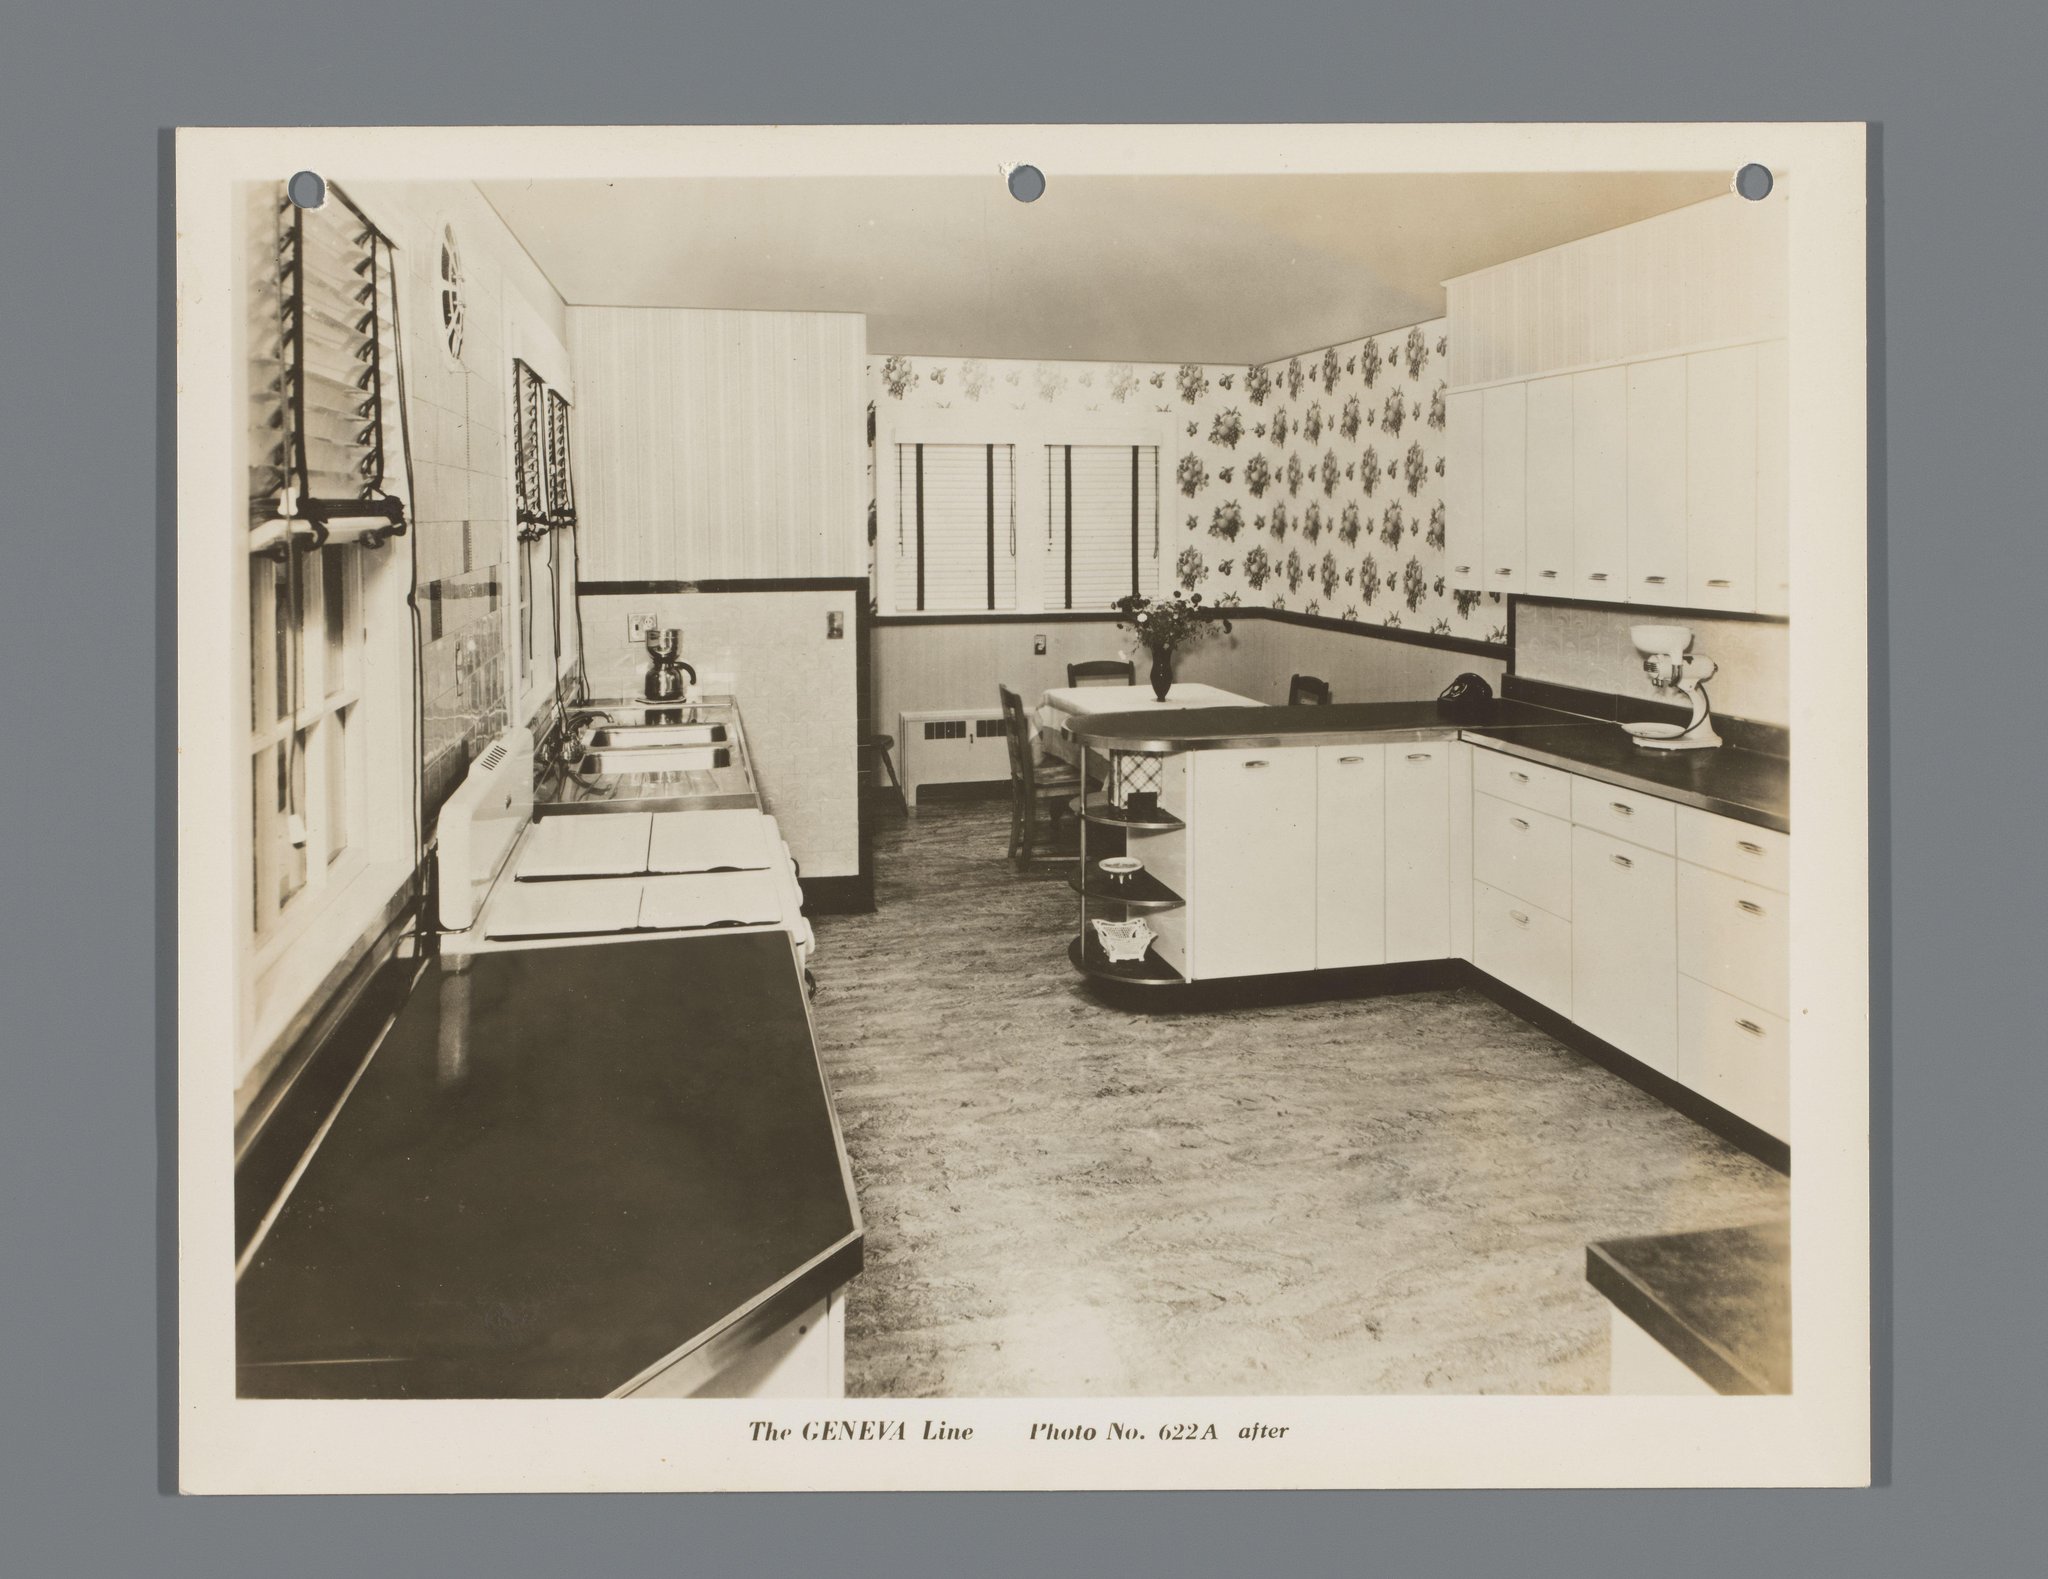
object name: photograph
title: Keuken Geneva Line, after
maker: Anonymous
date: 1920-1930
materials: photographic support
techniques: gelatin silver print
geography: united states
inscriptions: inscription: ‘The GENEVA Line Photo No. 622A after’